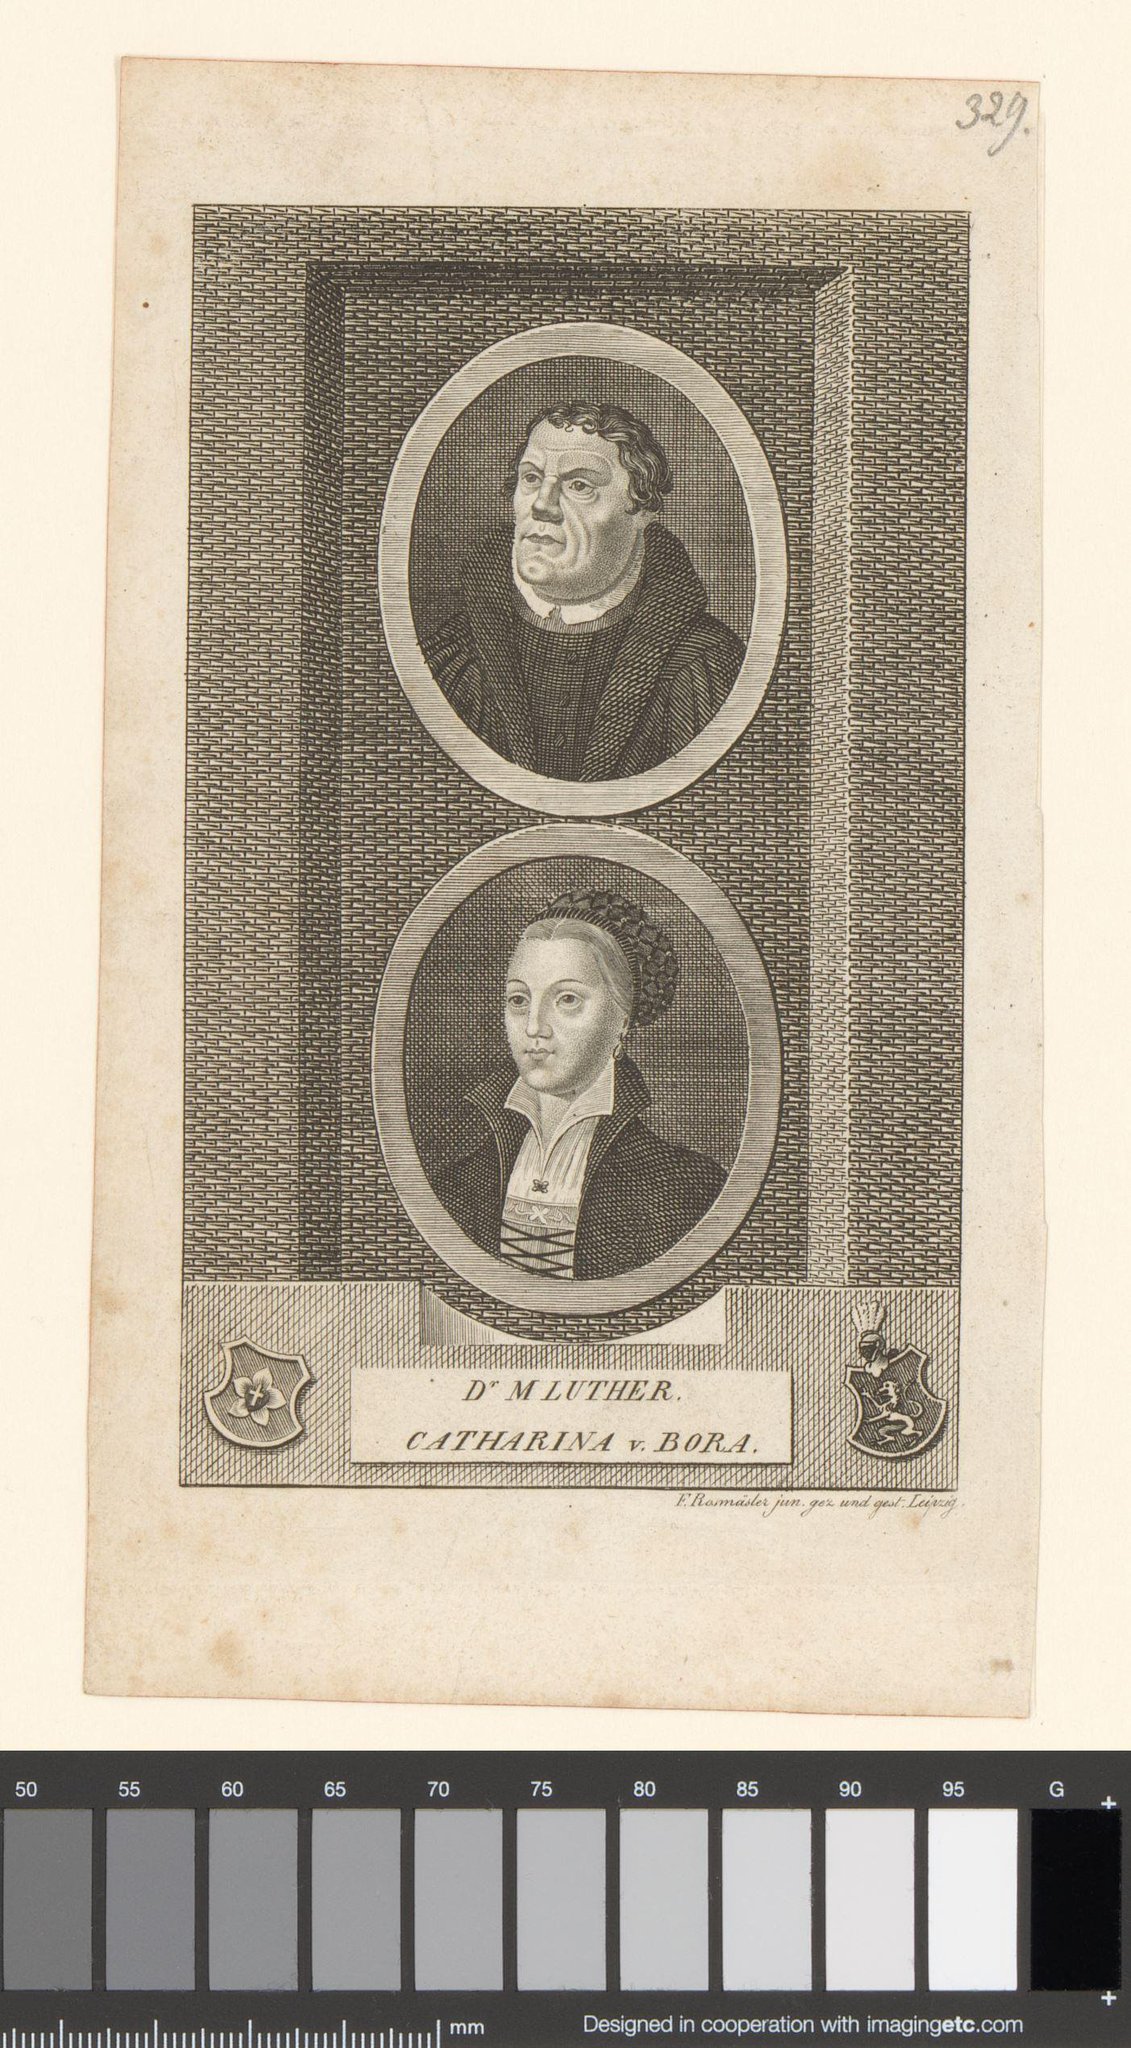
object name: print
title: Dubbelportret van Martin Luther en Katharina von Bora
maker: friedrich rossmässler junior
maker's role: artist, print maker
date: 1785-1858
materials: paper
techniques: engraving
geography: leipzig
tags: priest, martin luther, theologian, historical persons - bb - woman, historical person in a double portrait, historical persons, armorial bearing, heraldry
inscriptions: collector's mark: Lugt 2228